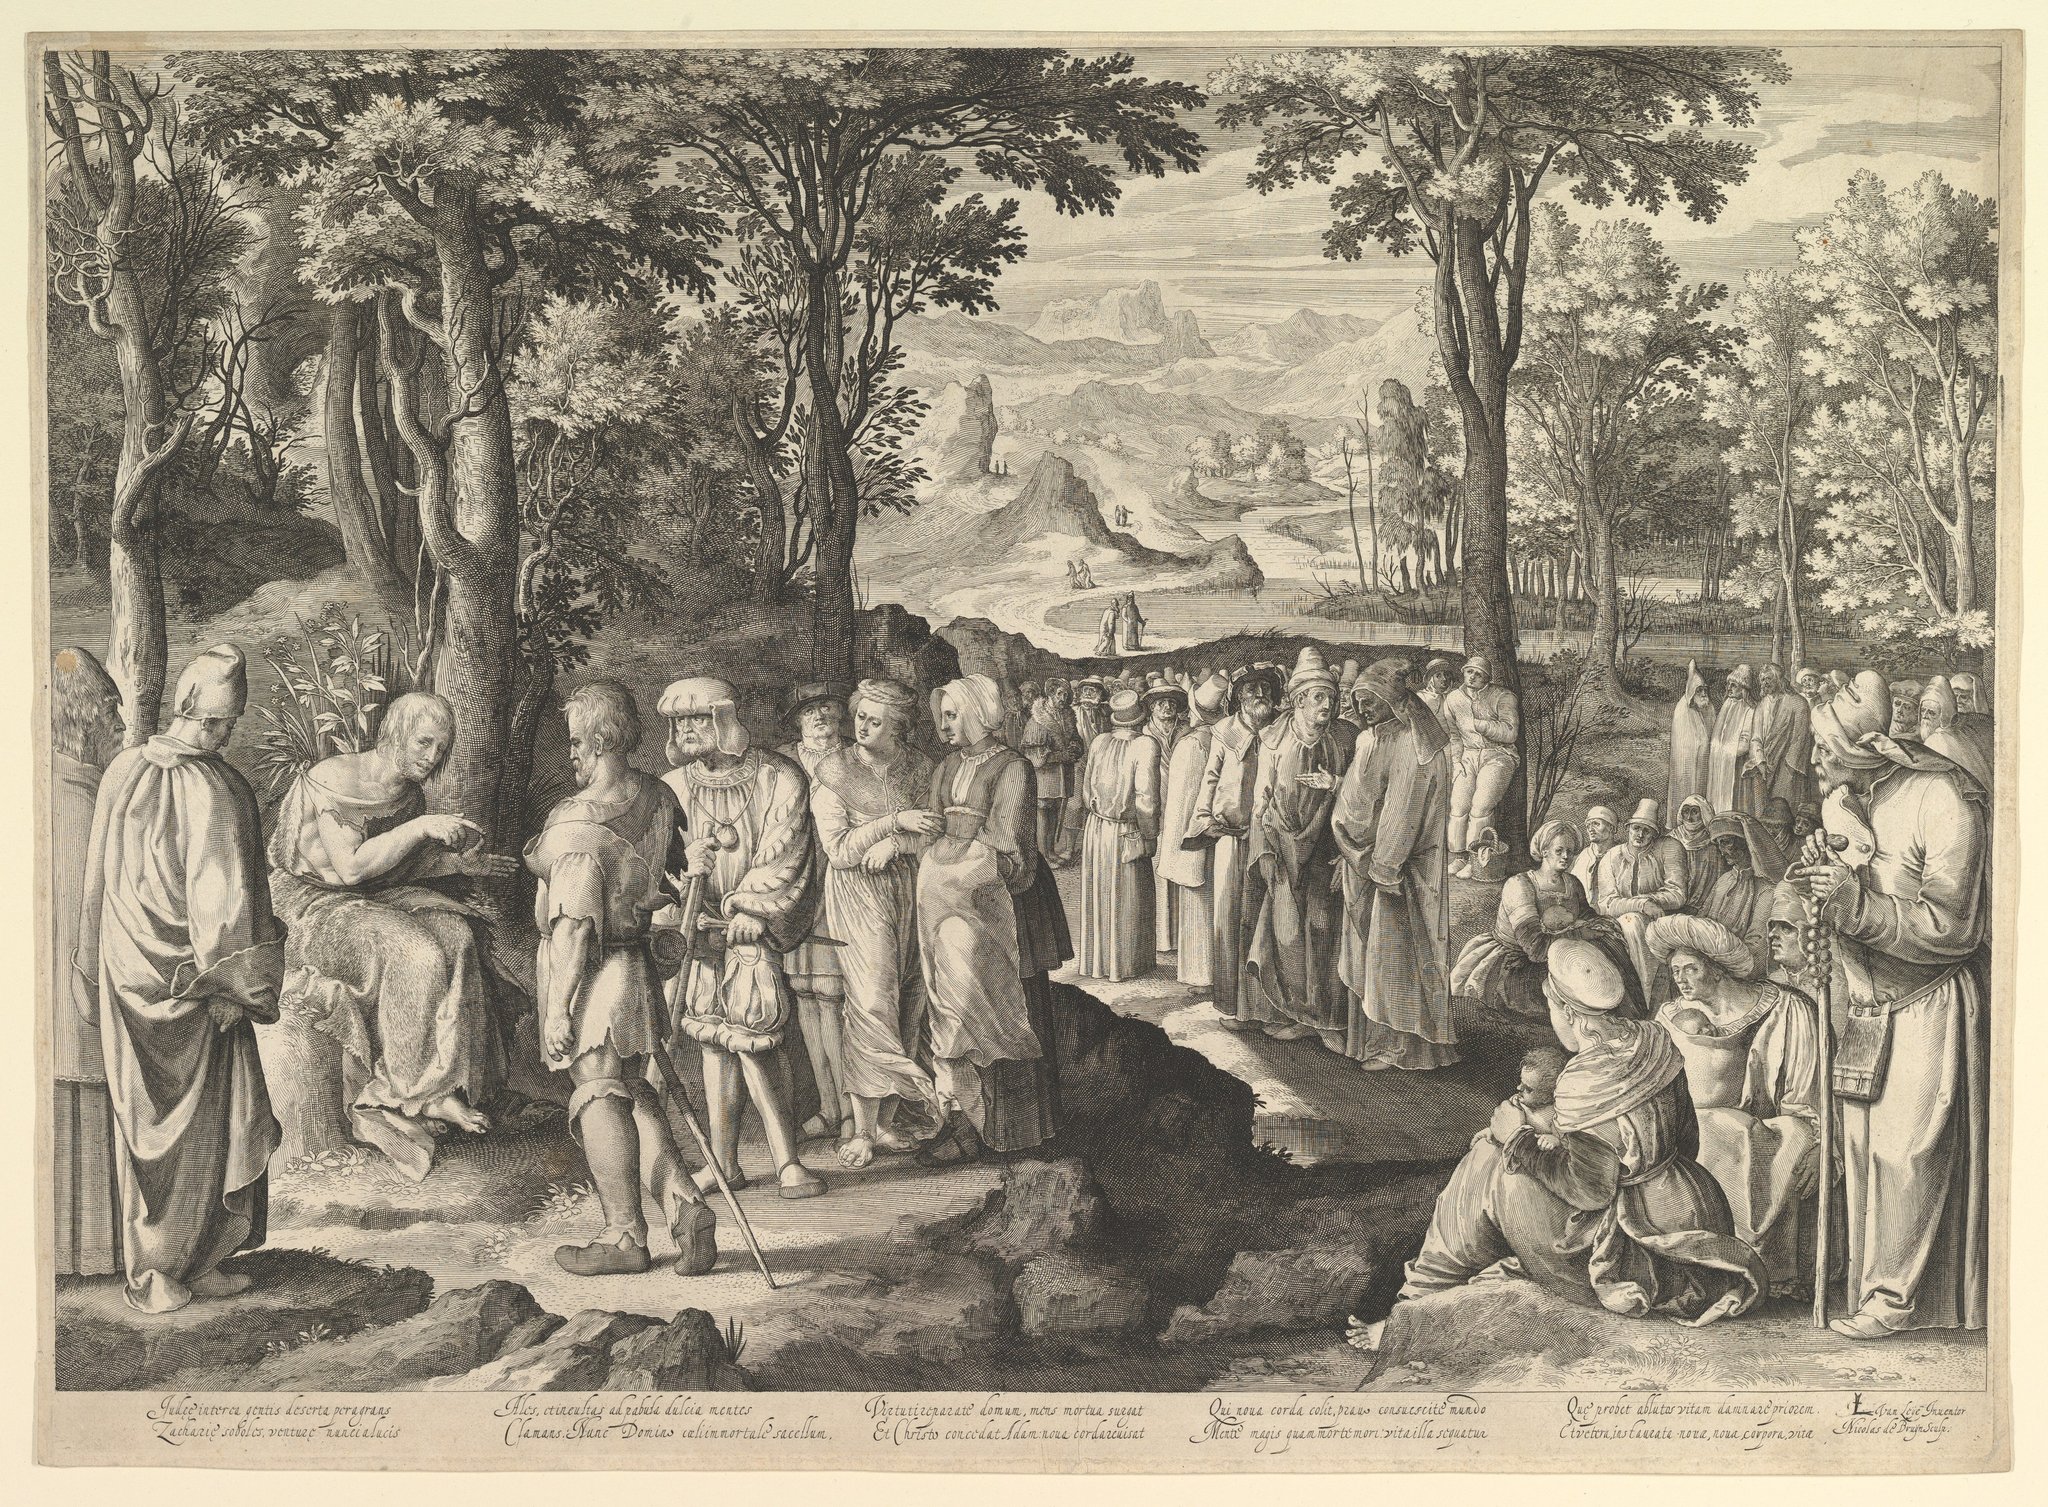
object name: print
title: John the Baptist Preaching in the Desert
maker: nicolaes de bruyn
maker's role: artist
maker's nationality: netherlandish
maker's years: 1571-1656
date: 1527-1528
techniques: engraving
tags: deserts,trees,saint john the baptist,crowd